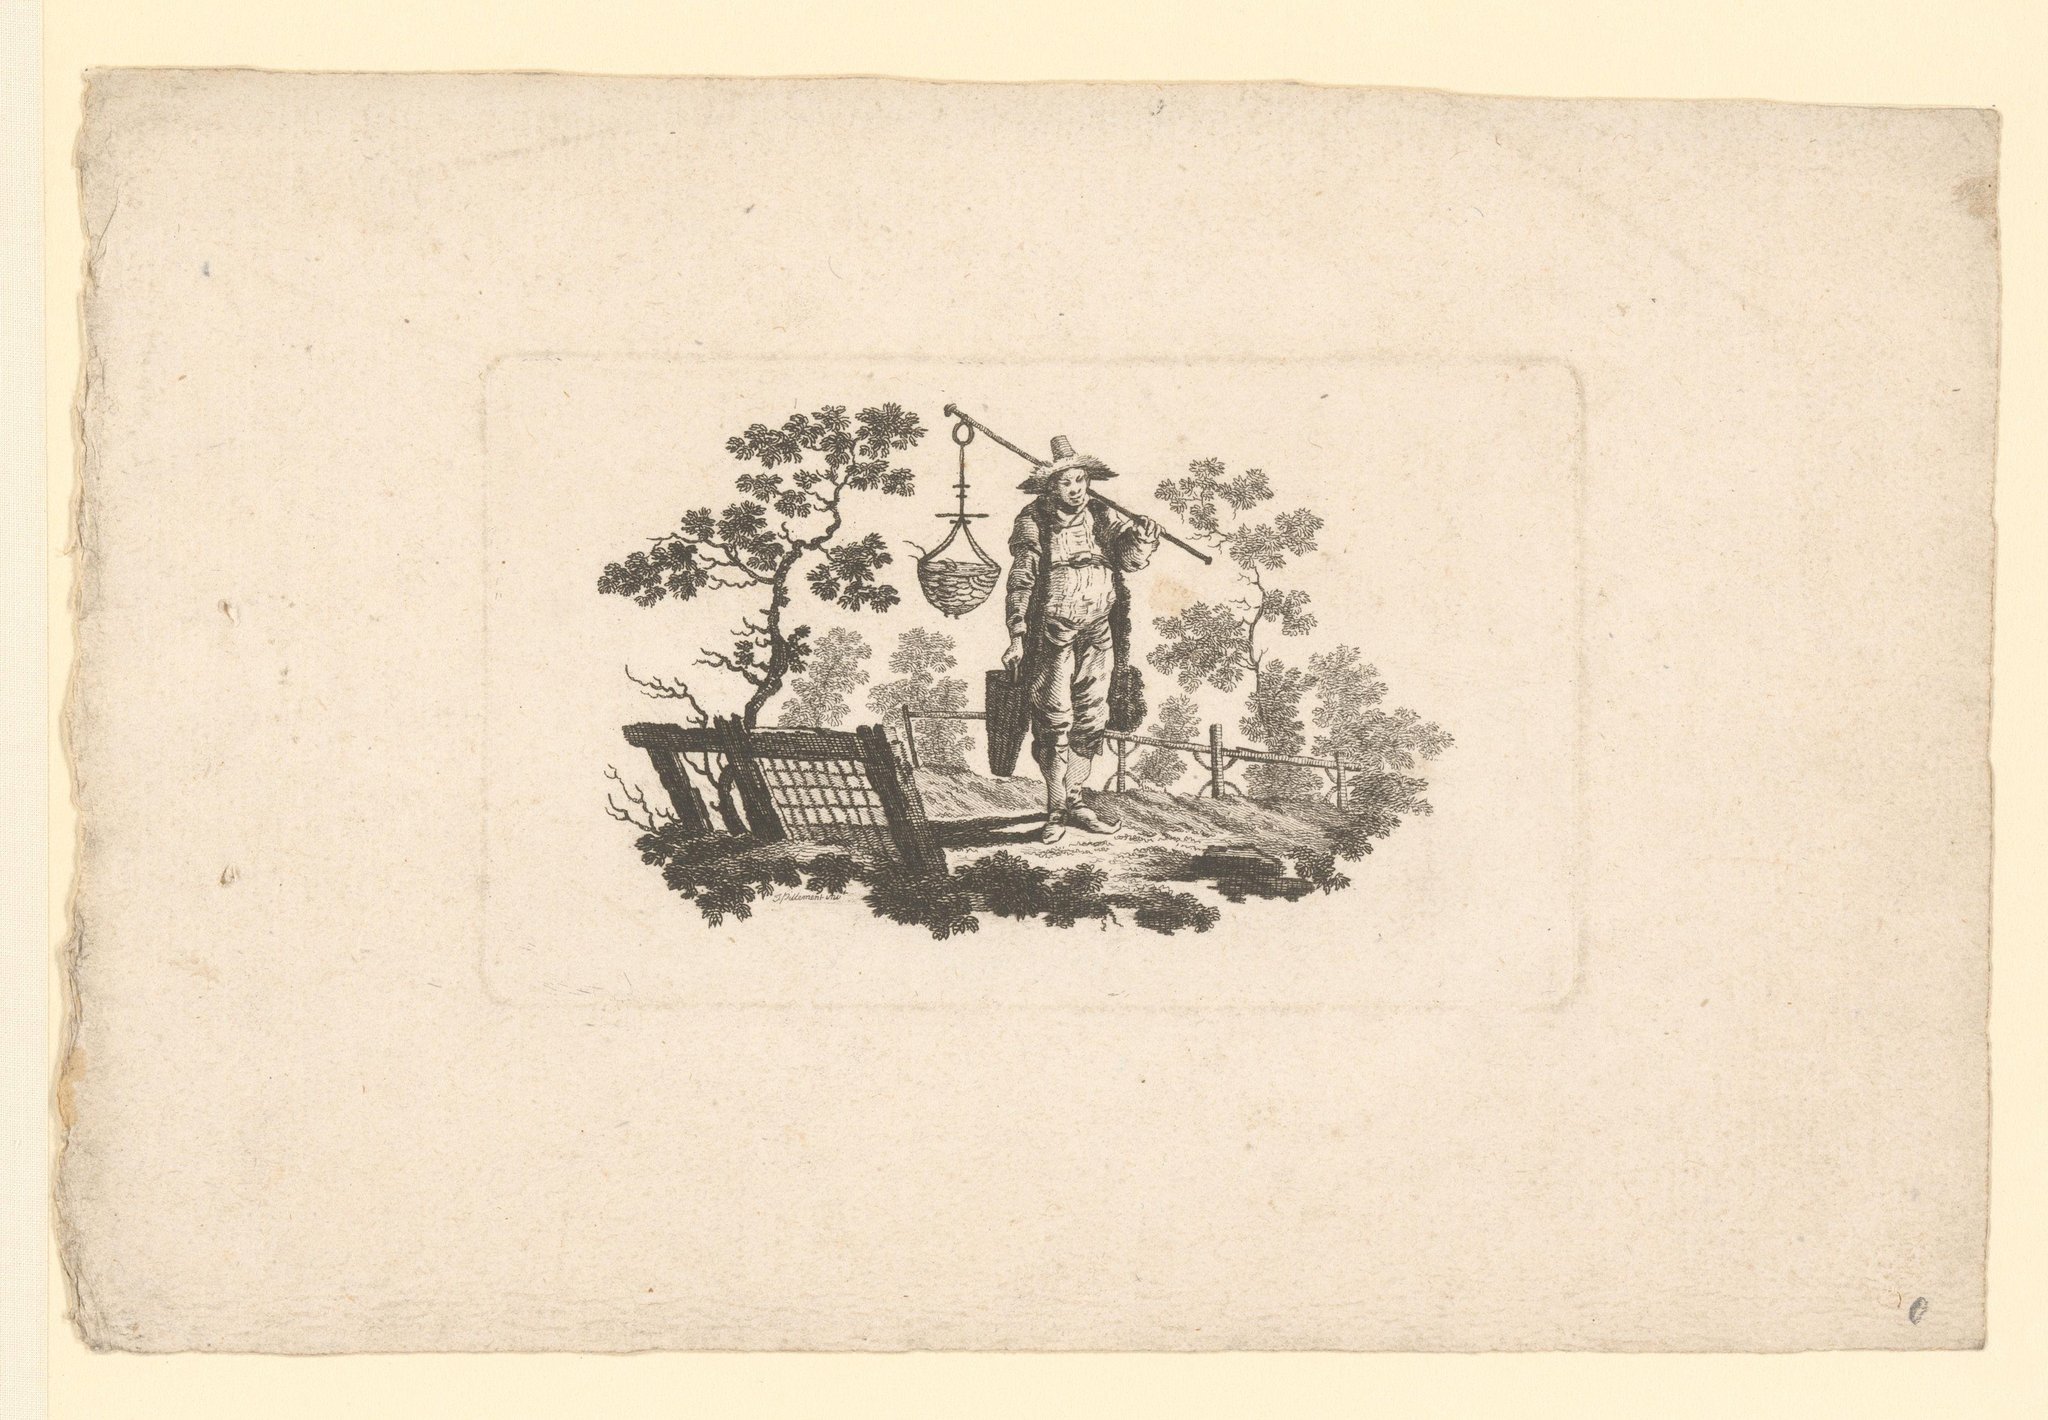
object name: print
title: Livre de Chinois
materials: paper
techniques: etching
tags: carrying something in basket, bag, rucksack, etc., landscapes (+ landscape with figures, staffage)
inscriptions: collector's mark: Lugt 2228, collector's mark: Lugt 2760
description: Een man loopt met twee manden in een landschap.